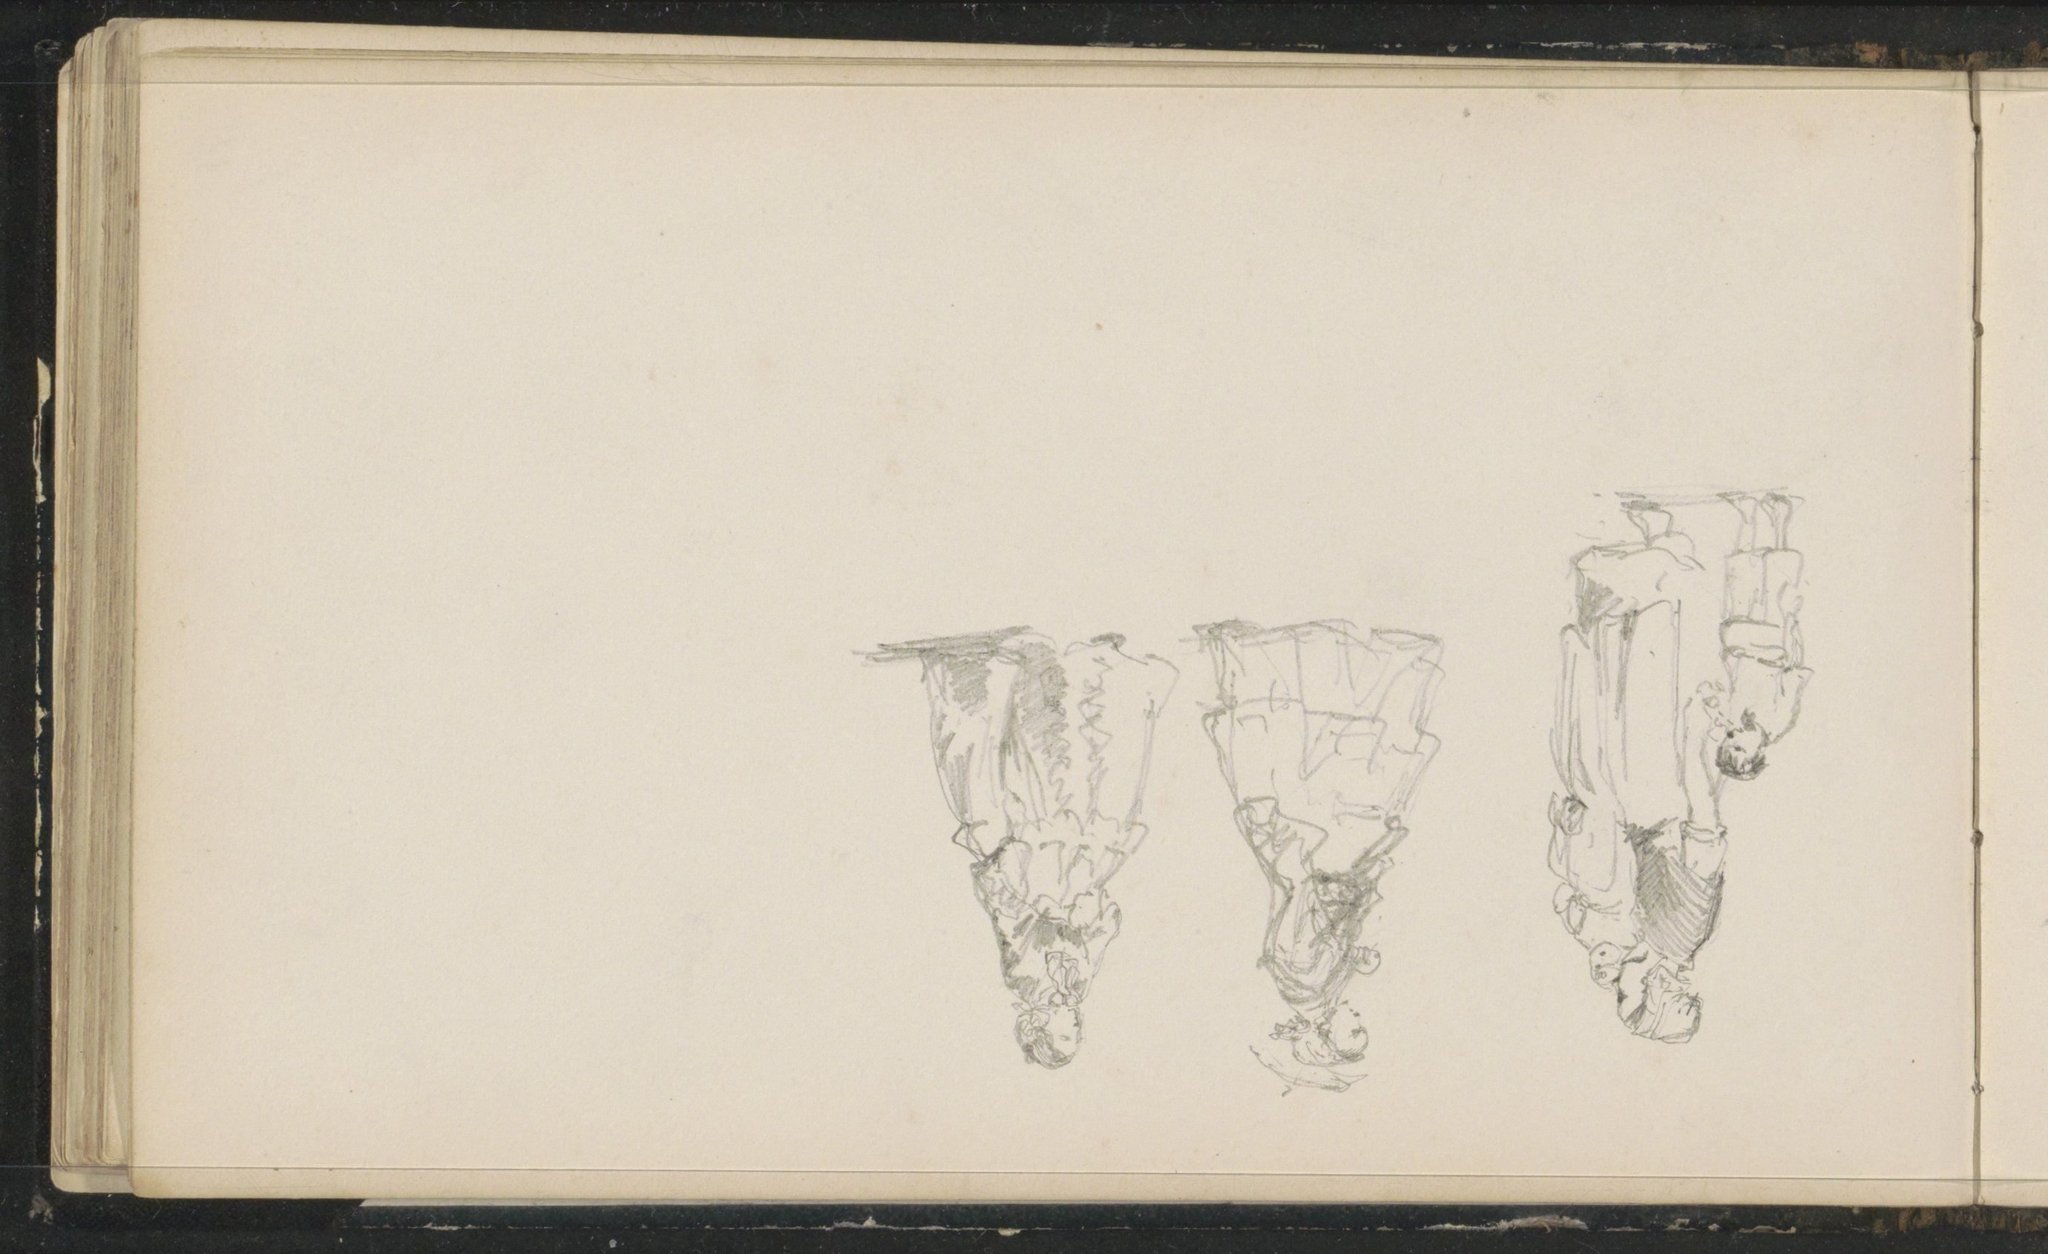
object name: sketchbook leaf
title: Studieblad met vrouwen en kinderen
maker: cornelis springer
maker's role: draughtsman, painter, print maker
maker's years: 1817-1891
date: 1856-1861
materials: paper, pencil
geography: zeeland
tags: adult woman, child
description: Vrouw met twee kinderen. Ernaast nog twee vrouwen. Blad 23 verso uit een schetsboek met 44 bladen vervaardigd in Zeeland en Utrecht.